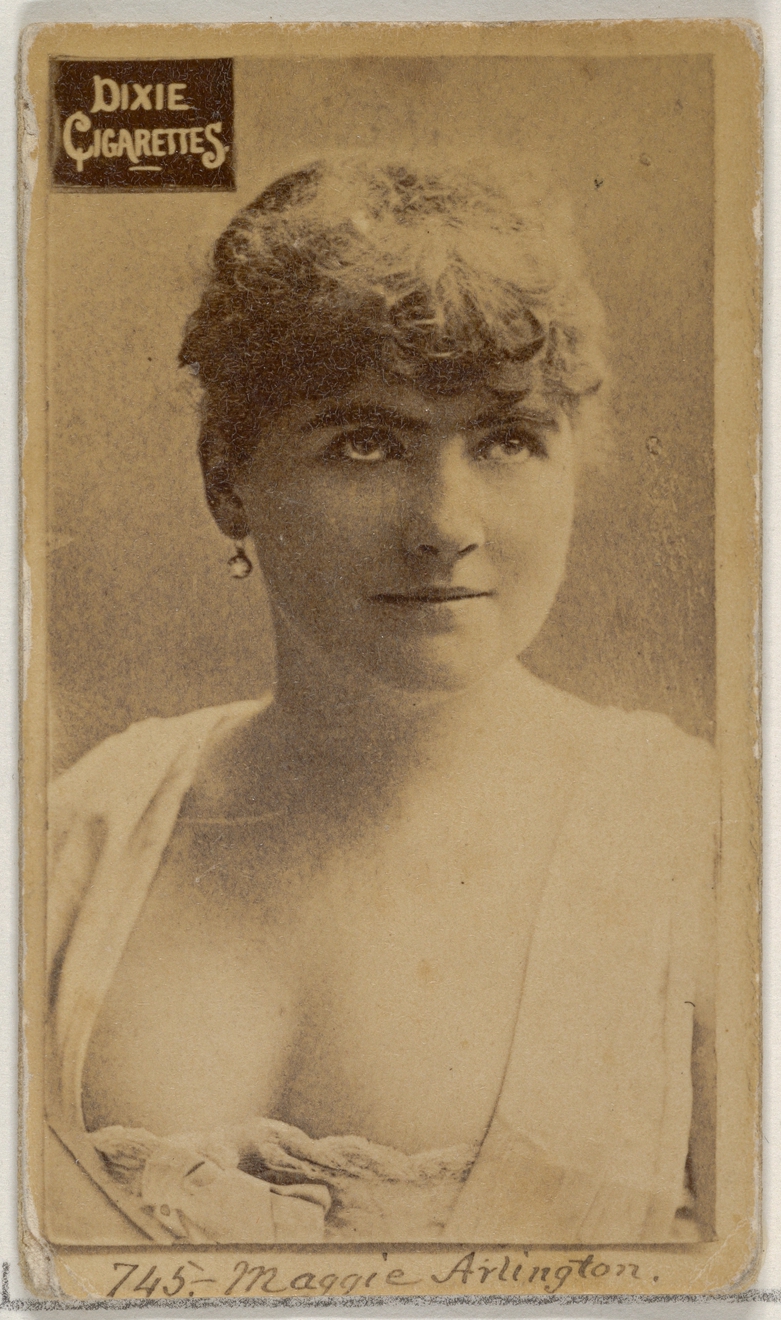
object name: photograph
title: Card 745, Maggie Arlington, from the Actors and Actresses series (N45, Type 7) for Dixie Cigarettes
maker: allen & ginter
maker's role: publisher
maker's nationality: american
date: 1888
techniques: albumen silver print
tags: portraits,women,actresses